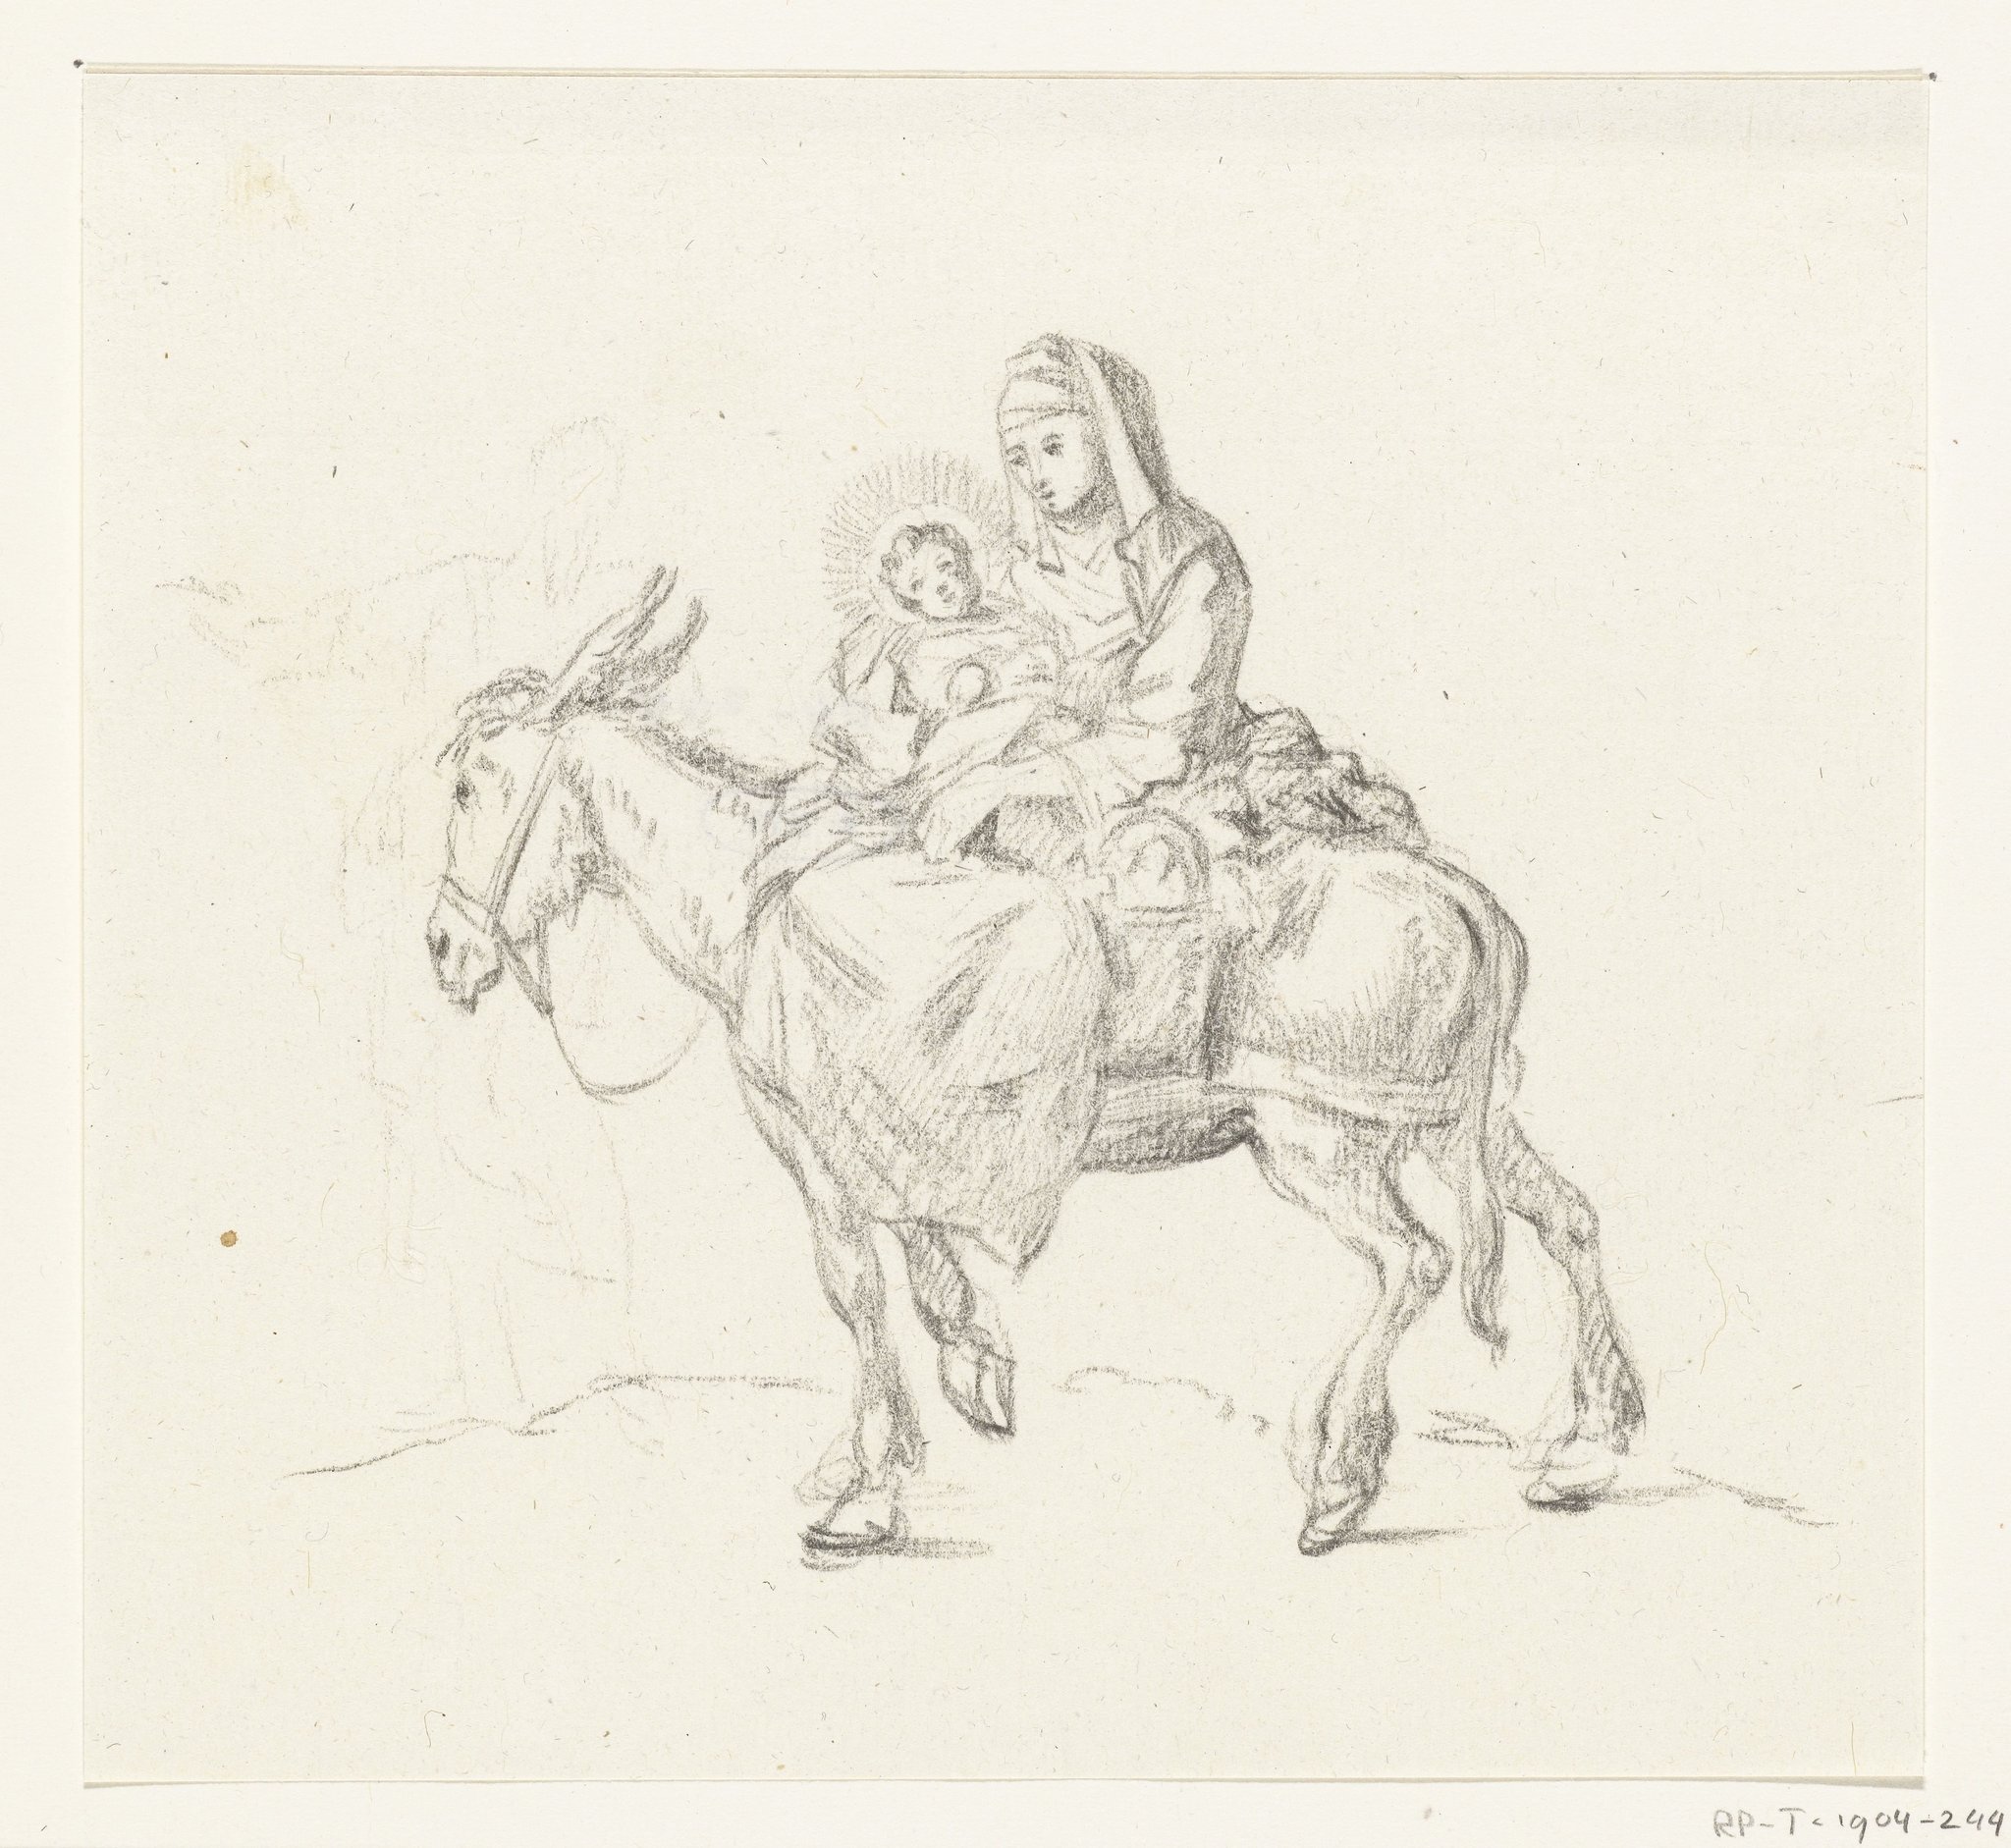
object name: drawing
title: Vlucht naar Egypte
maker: jean bernard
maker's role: draughtsman, print maker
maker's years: 1765-1833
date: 1775-1833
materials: chalk, paper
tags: the flight into egypt: mary, joseph, the child (and sometimes others) on their way; mary usually riding on an ass